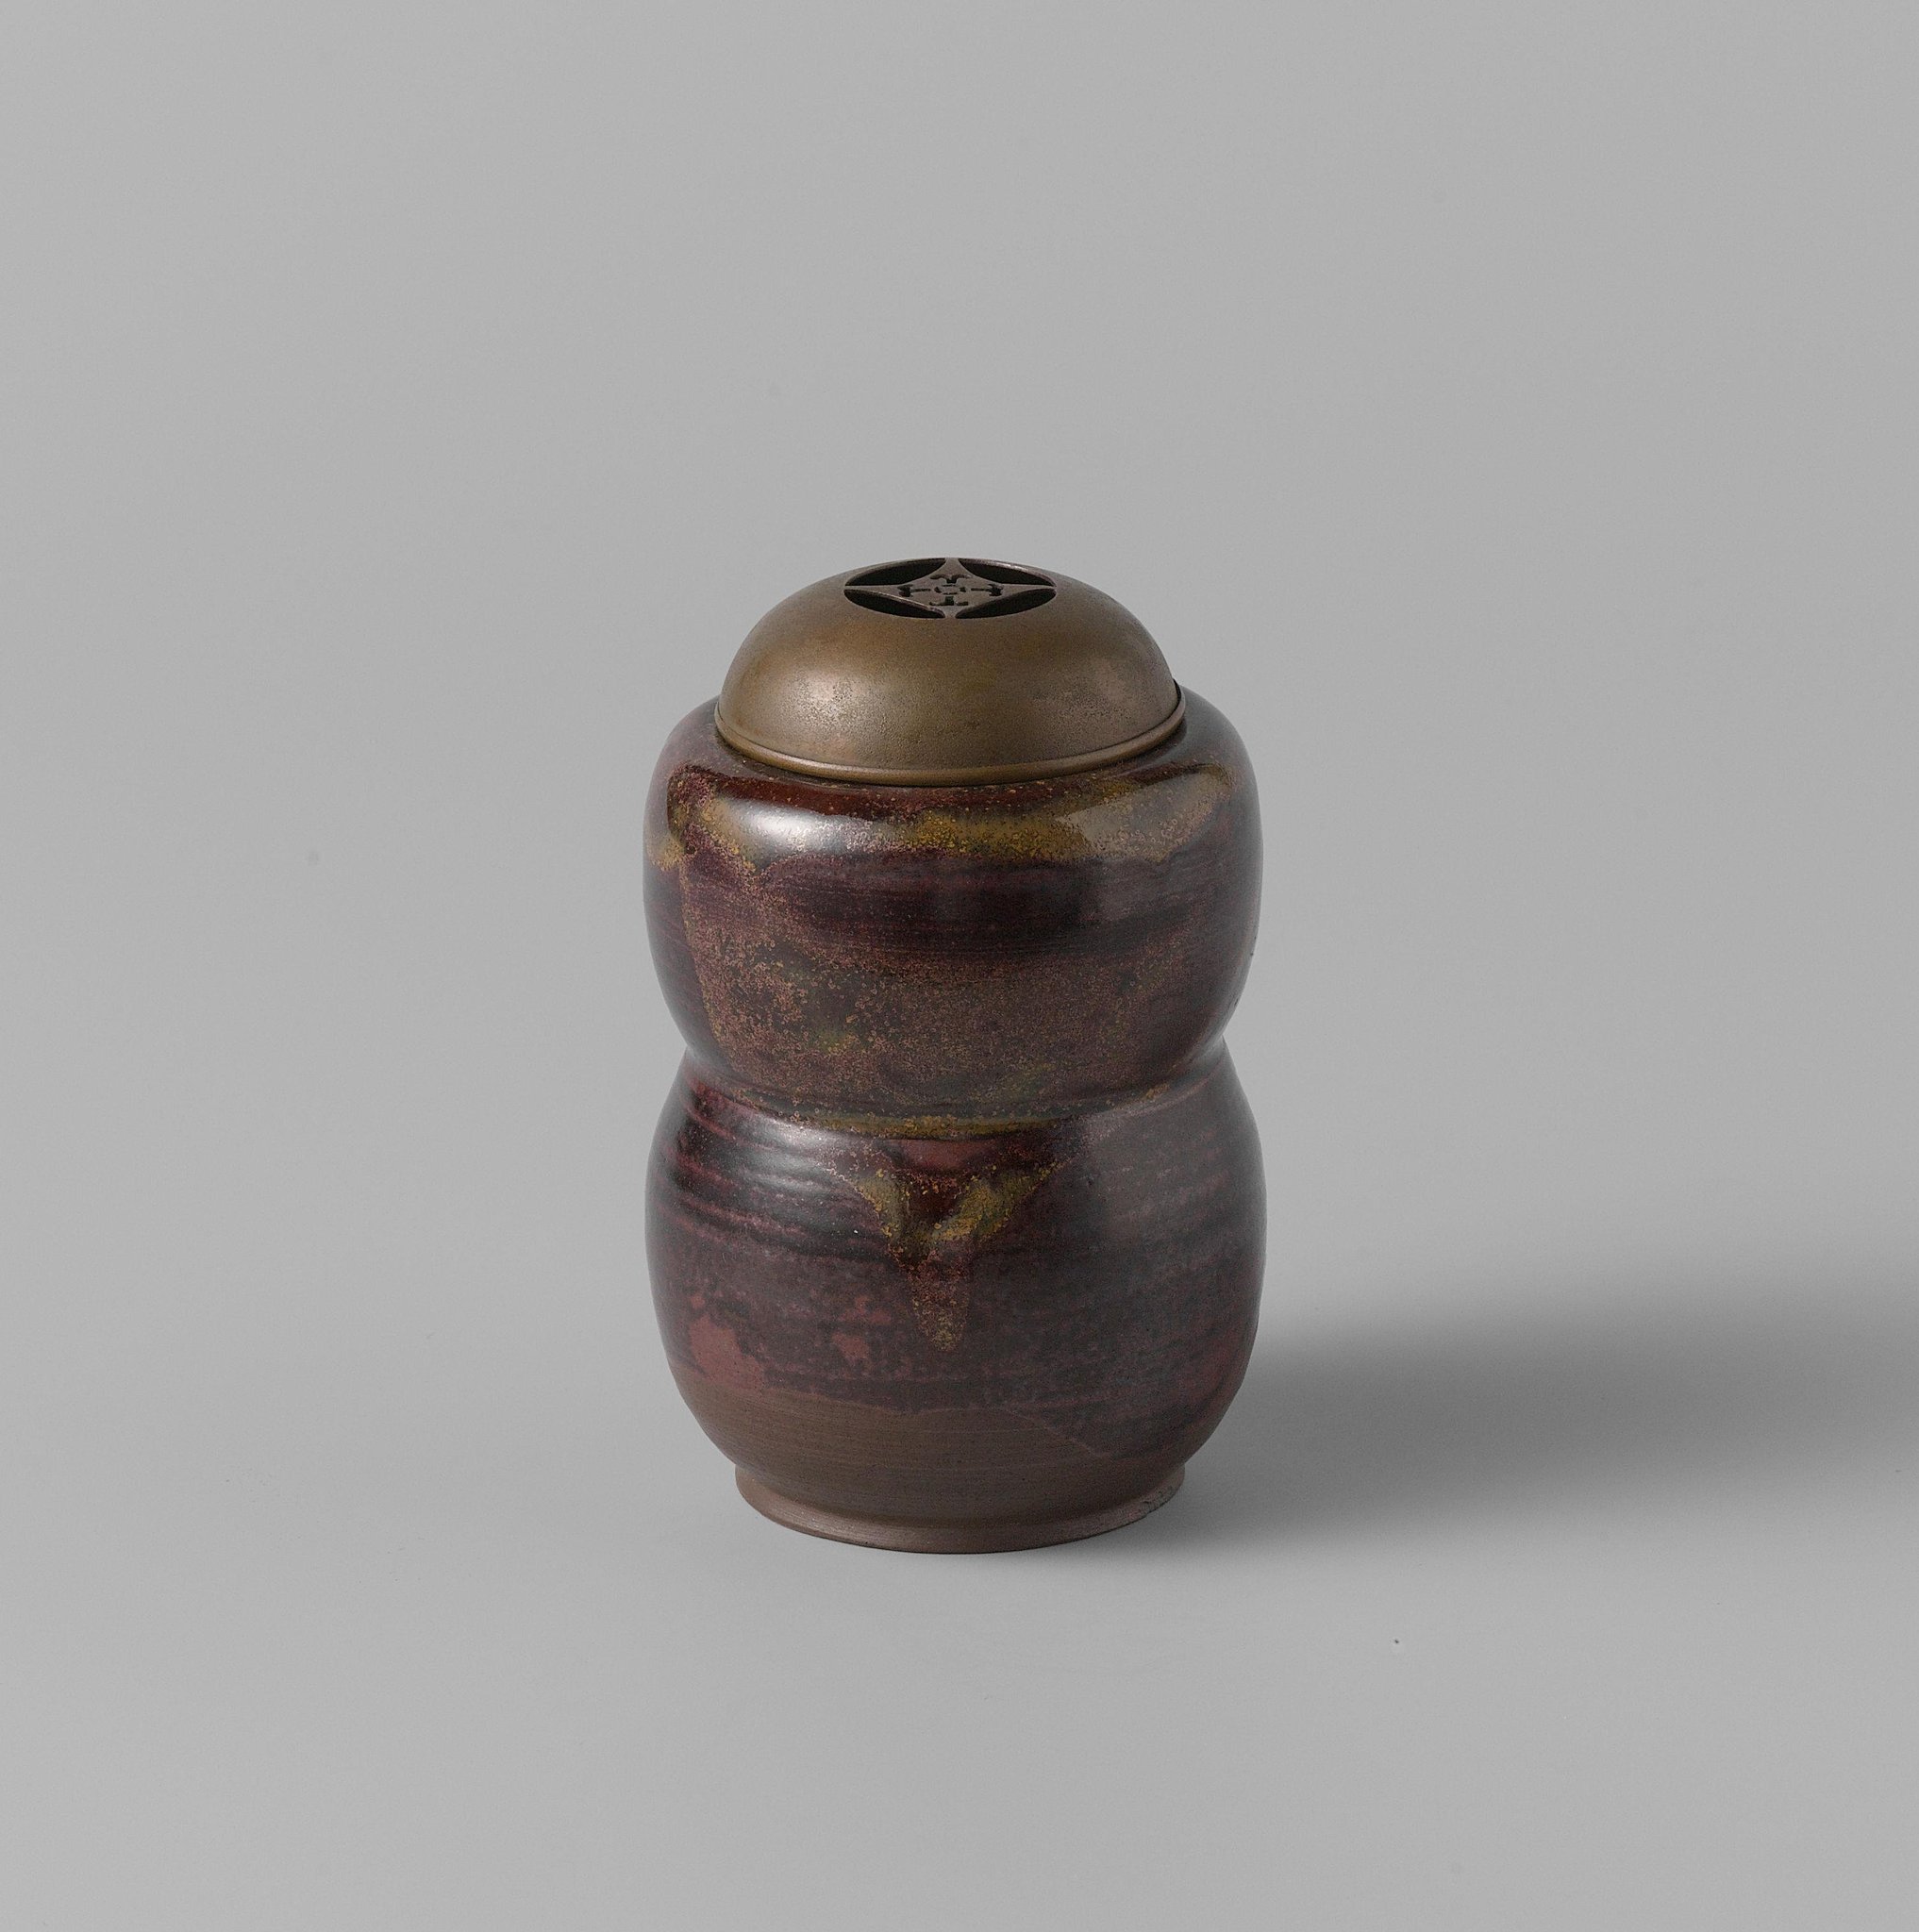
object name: hibachi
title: Insence burner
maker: Anonymous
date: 1600-1868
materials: glaze, metal, stoneware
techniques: firing, turning, vitrification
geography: takatori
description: Wierookbrander van steengoed met een dubbele kalebasvorm, gedeeltelijk bedekt met een aubergine en okerkleurig glazuur (Takatori of Shigaraki).